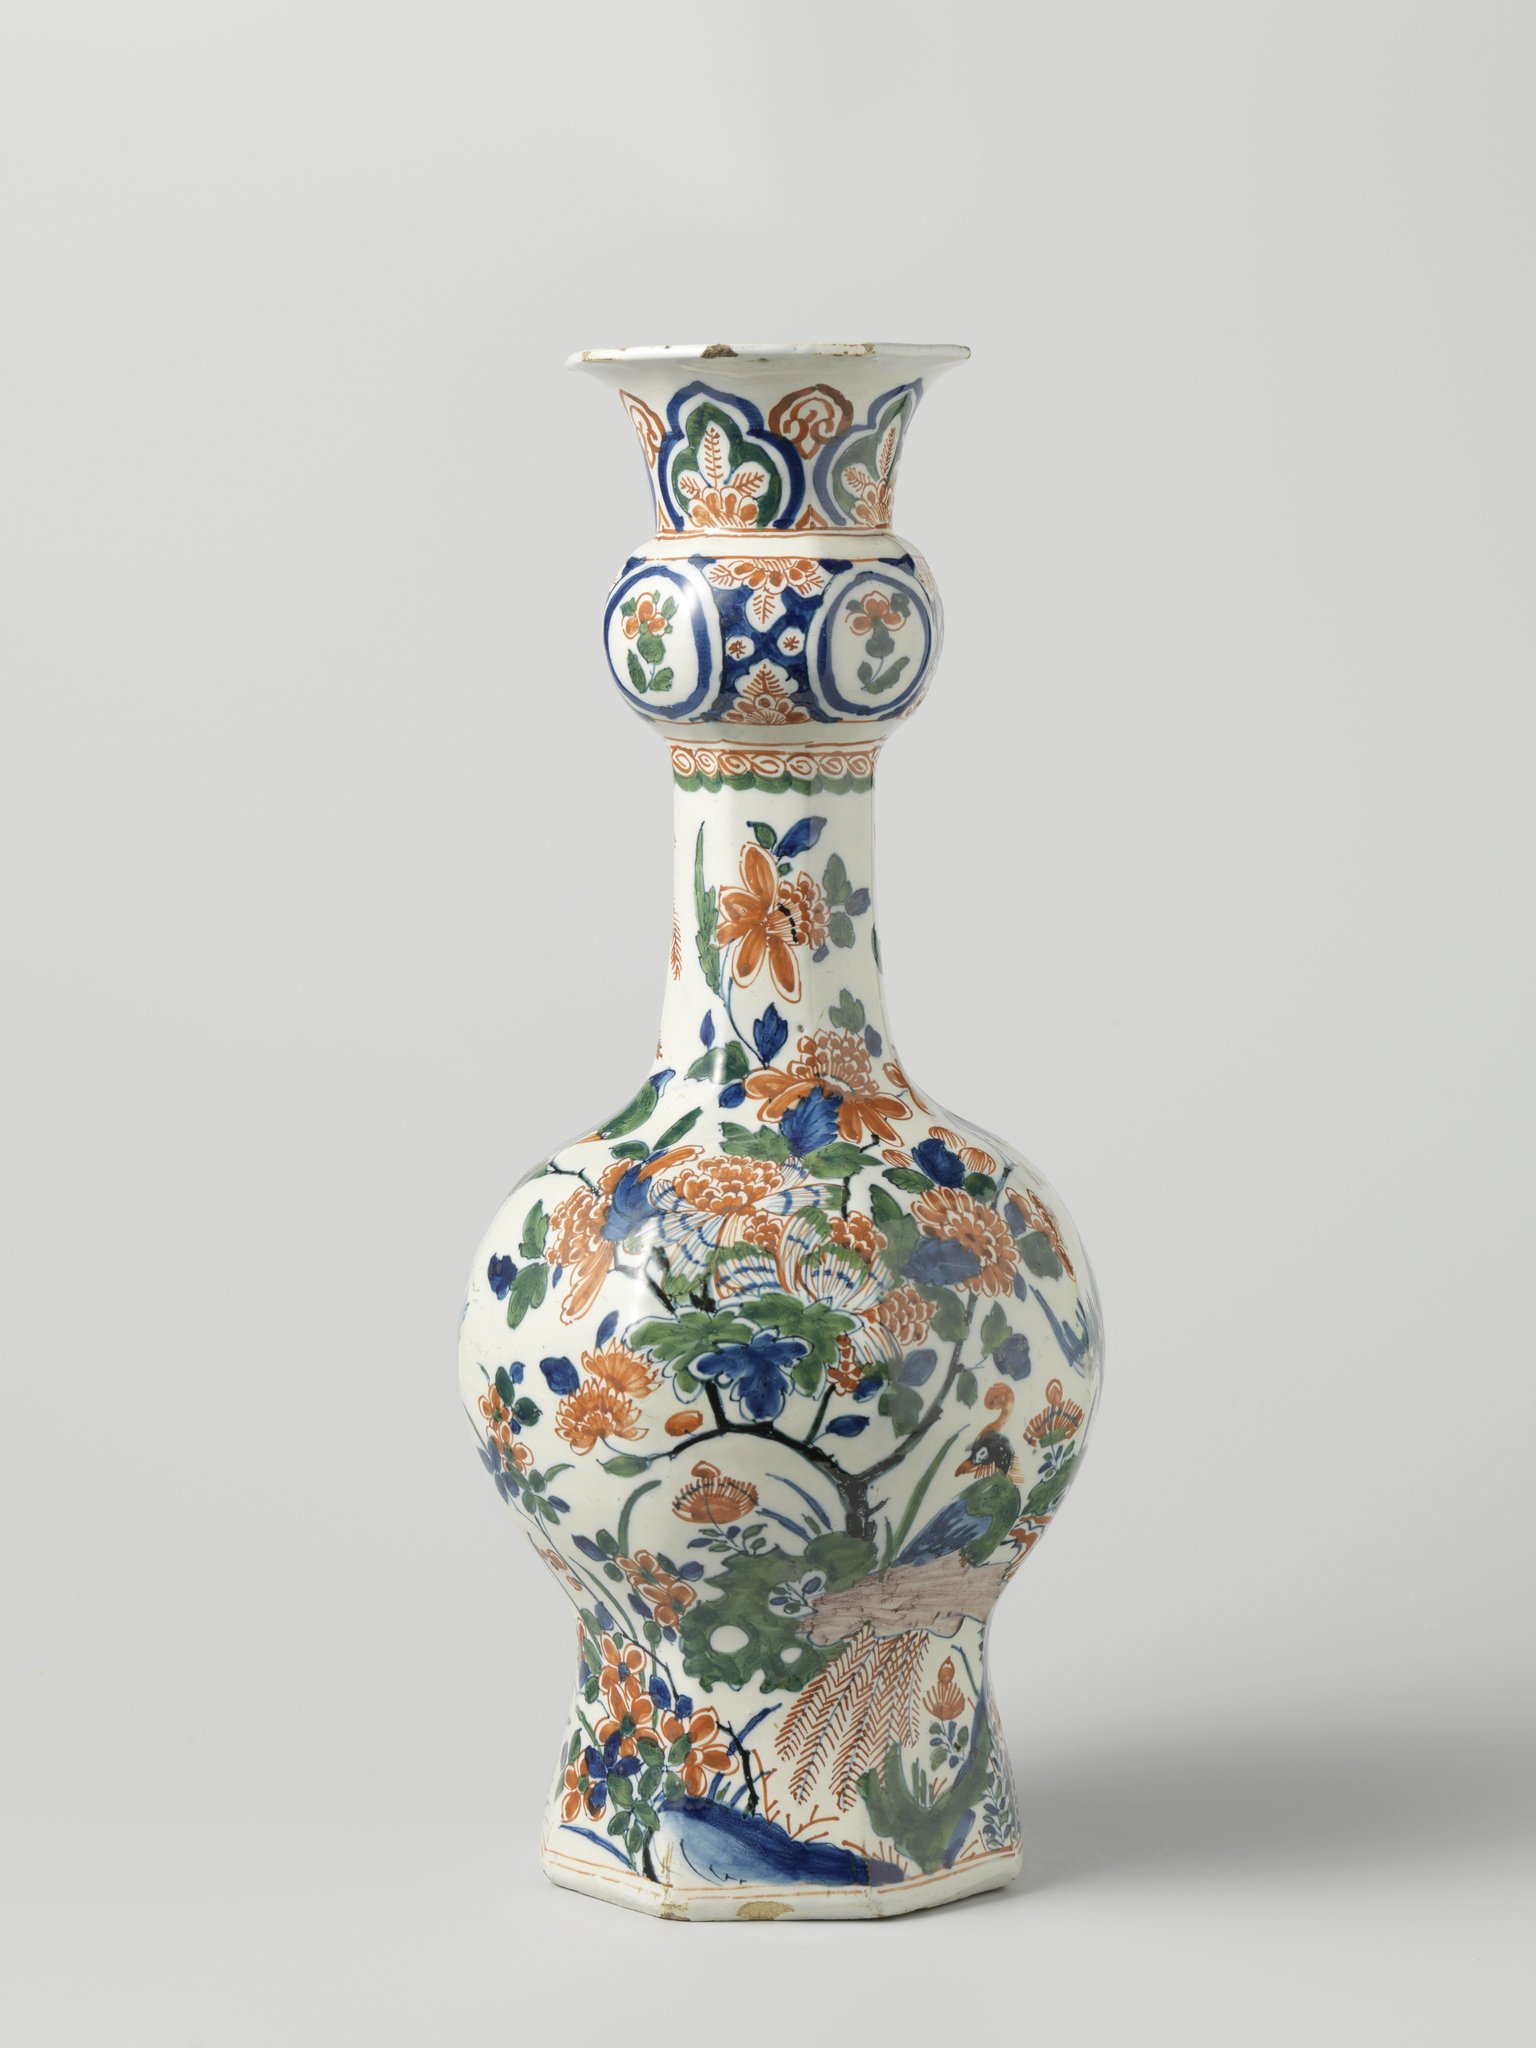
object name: knobbelvaas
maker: Anonymous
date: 1720-1750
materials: earthenware, glaze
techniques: painted, polychromy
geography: delft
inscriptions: label: ‘14’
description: knobbelvaas van veelkleurig beschilderde faience. De vaas is achthoekig en is beschilderd met planten, bloemen en vogels in de kleuren groen, rood, blauw, mangaan en zwart. Bij de vaas hoort een identieke fles met het invnr. BK-NM-11637-b.